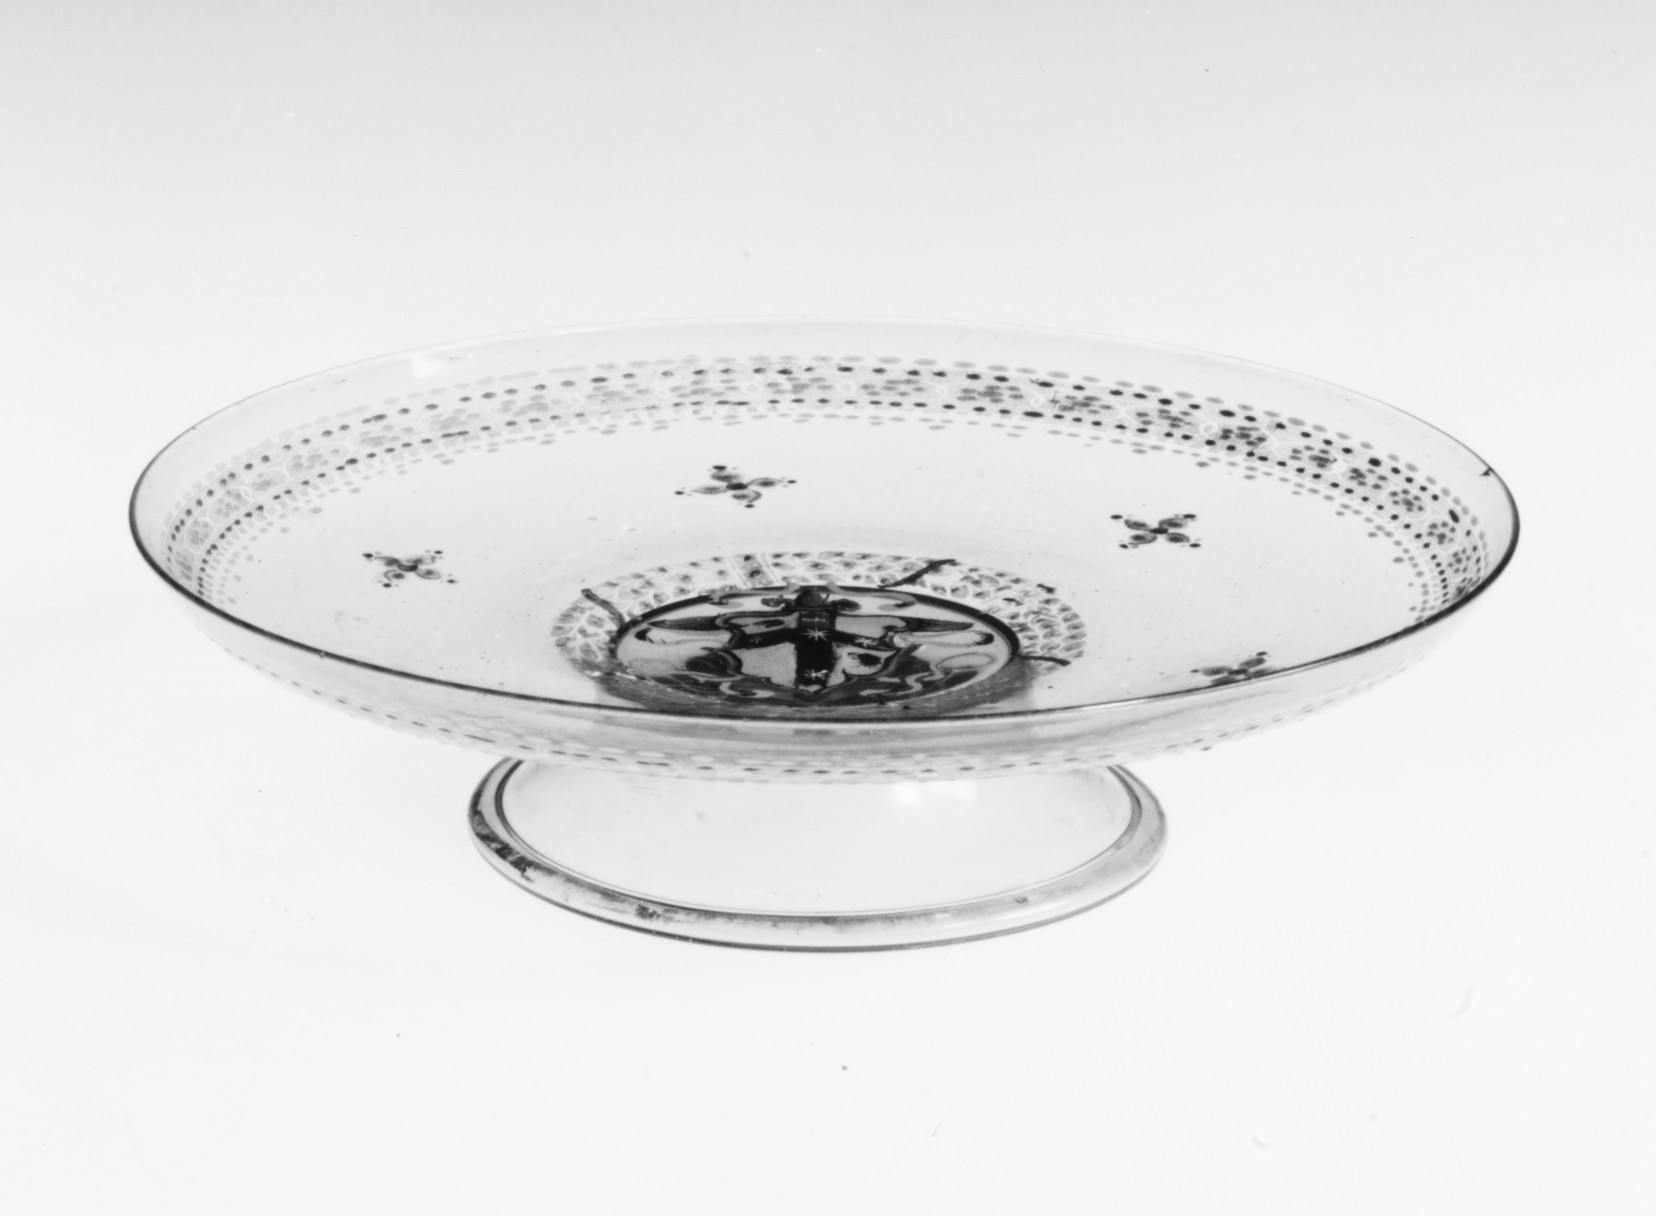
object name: tazza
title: Armorial tazza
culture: italian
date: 1500-1525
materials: gilt, glass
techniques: glassblowing, enamel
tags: coat of arms